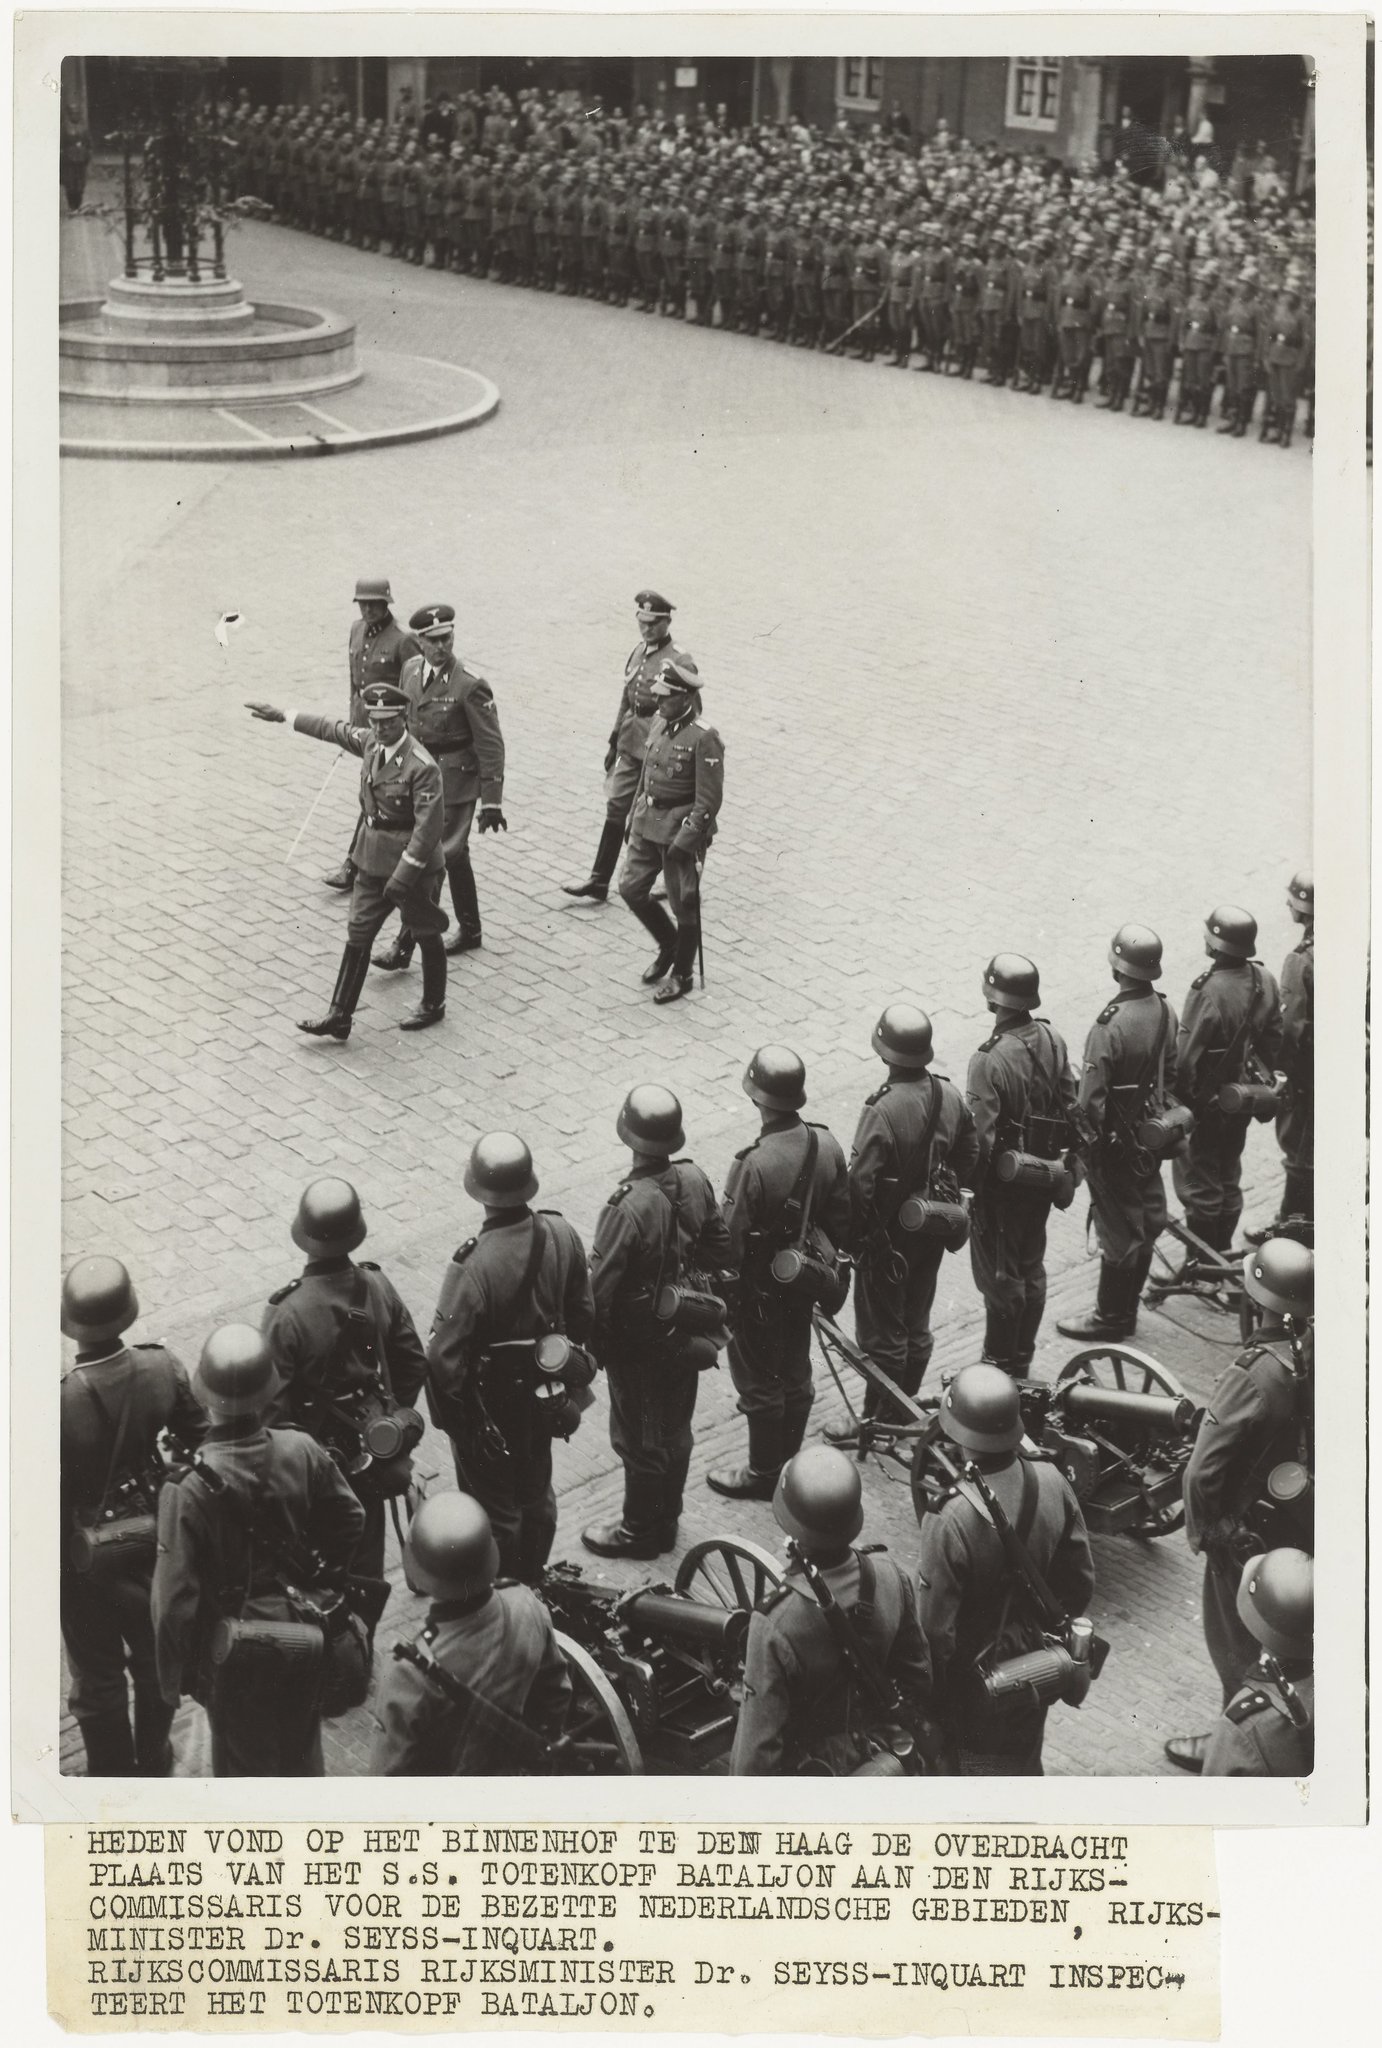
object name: photograph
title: Seyss Inquart inspecteert het Totenkopf Bataljon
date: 1940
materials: photographic support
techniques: photography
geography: the hague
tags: politician, arthur seyss-inquart, review, inspection (of company, unit, troop), the hague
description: Rijkscommissaris Seyss Inquart inspecteert op het Binnenhof het aangetreden Totenkopf Bataljon. De officiële benaming was: Totenkopf Standarte, onderdeel van de Waffen SS. Zij waren betrokken bij de februari staking in 1941. Tekststrookje aan foto geplakt.